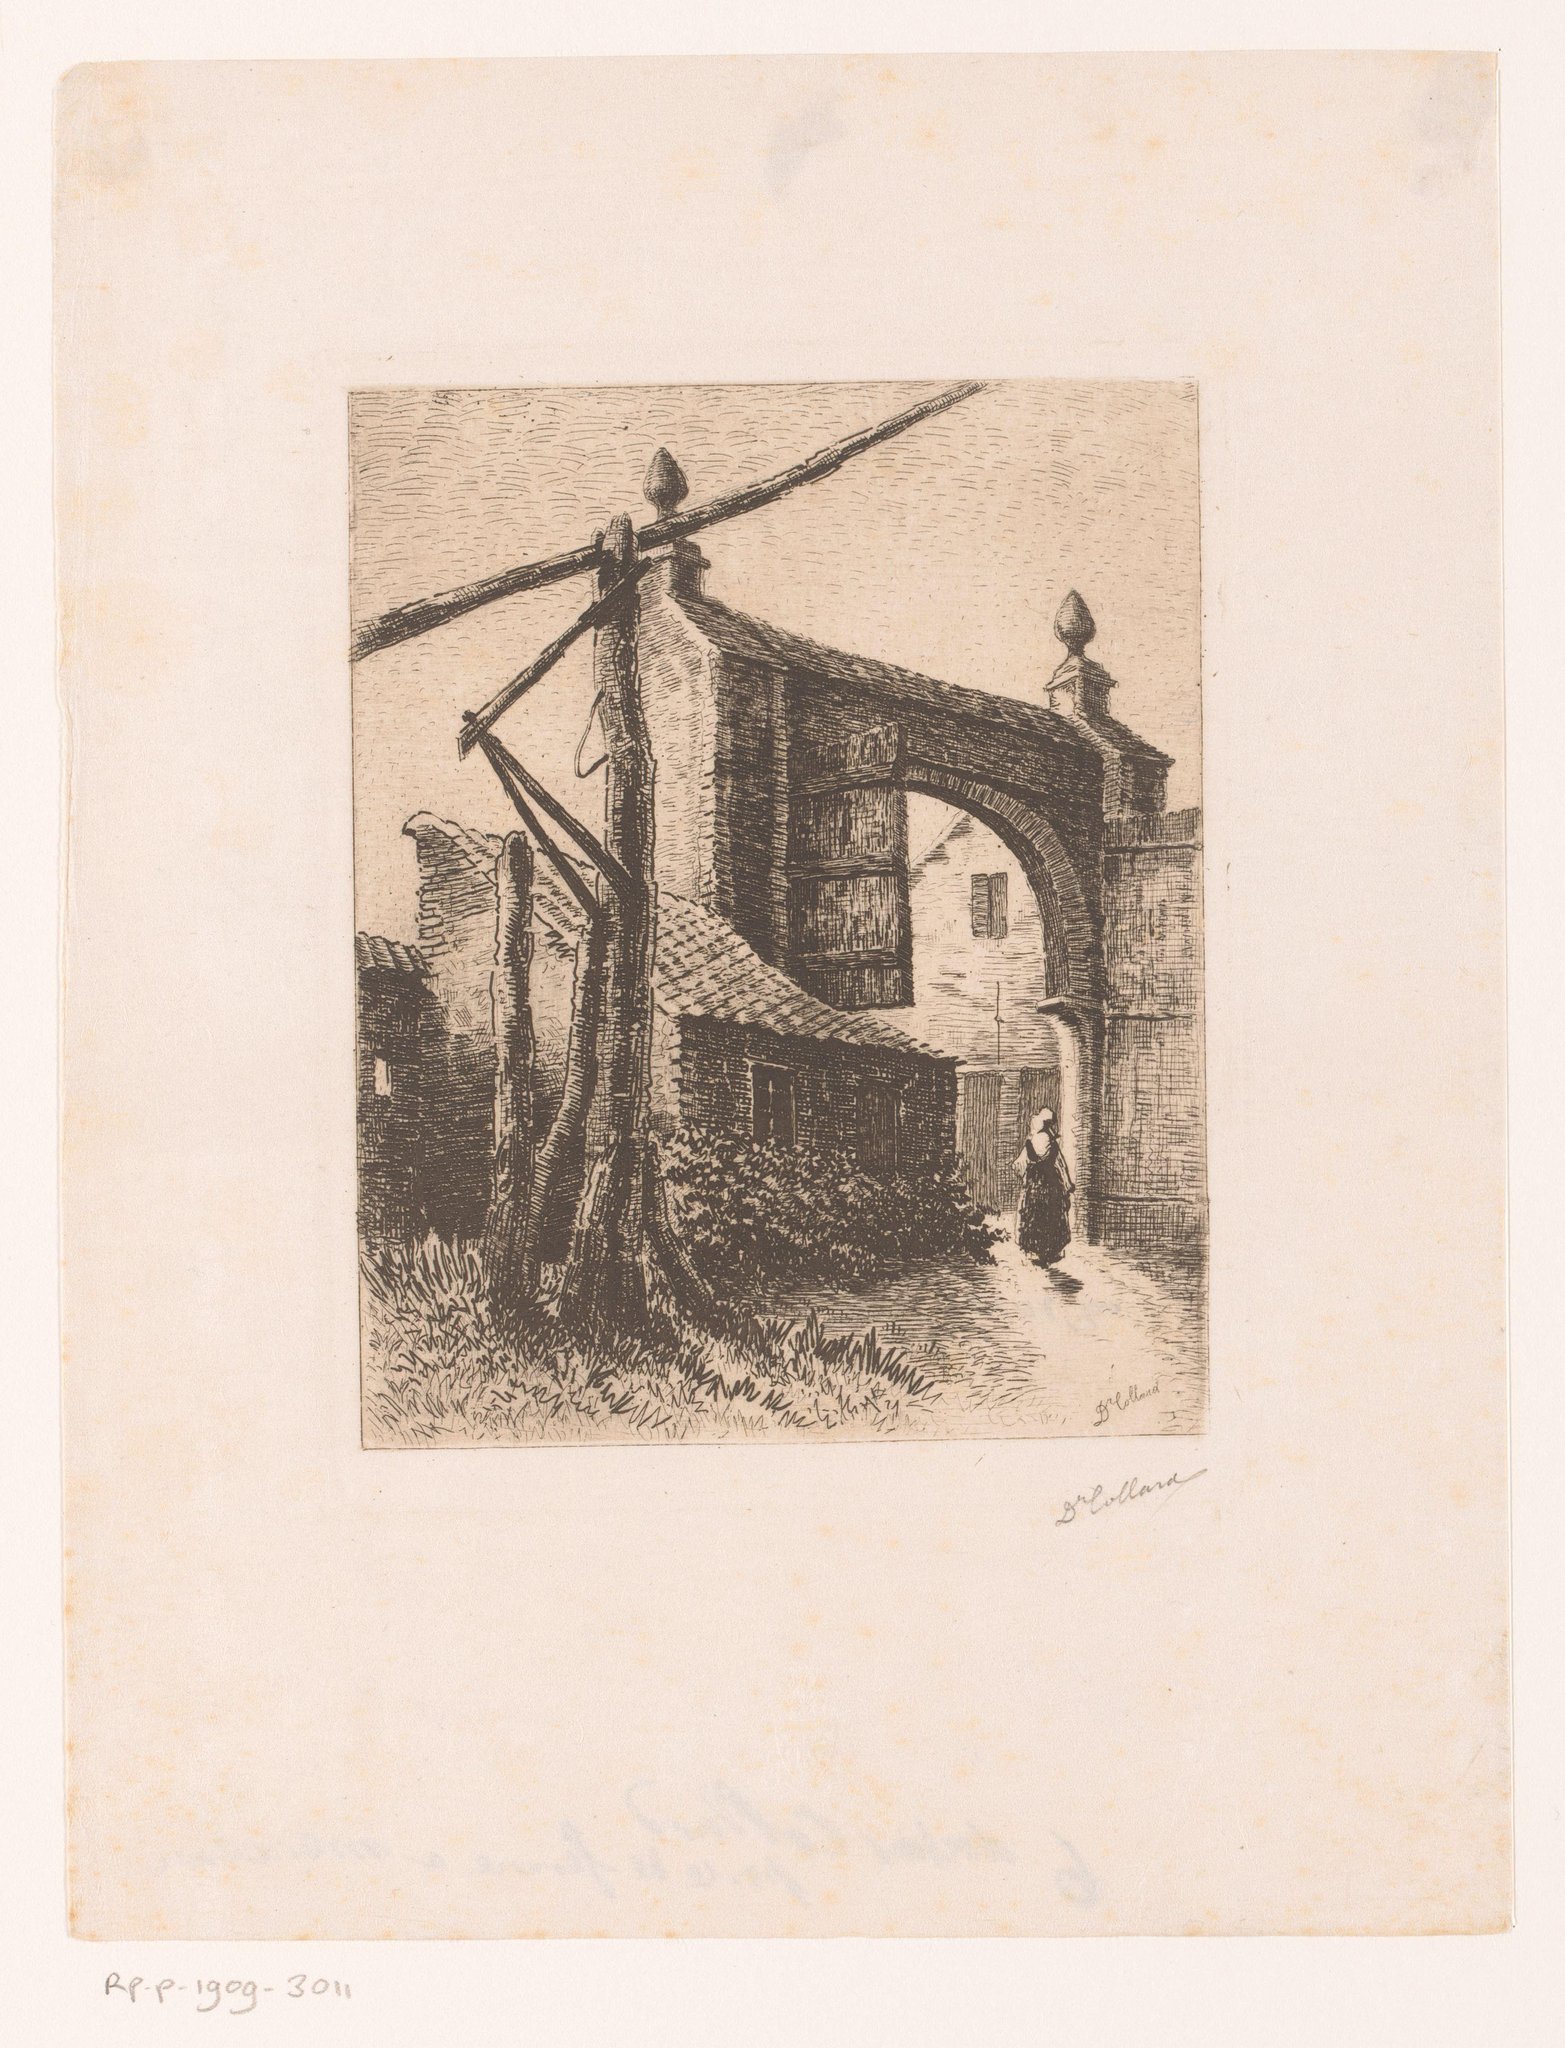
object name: print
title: Vrouw bij een poort te Merksem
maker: armand collard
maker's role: print maker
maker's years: 1838-1910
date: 1848-1909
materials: paper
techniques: etching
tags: adult woman, village-gate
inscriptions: mark: ‘Antwerpsche Etsers 1880’, collector's mark: Lugt 2228